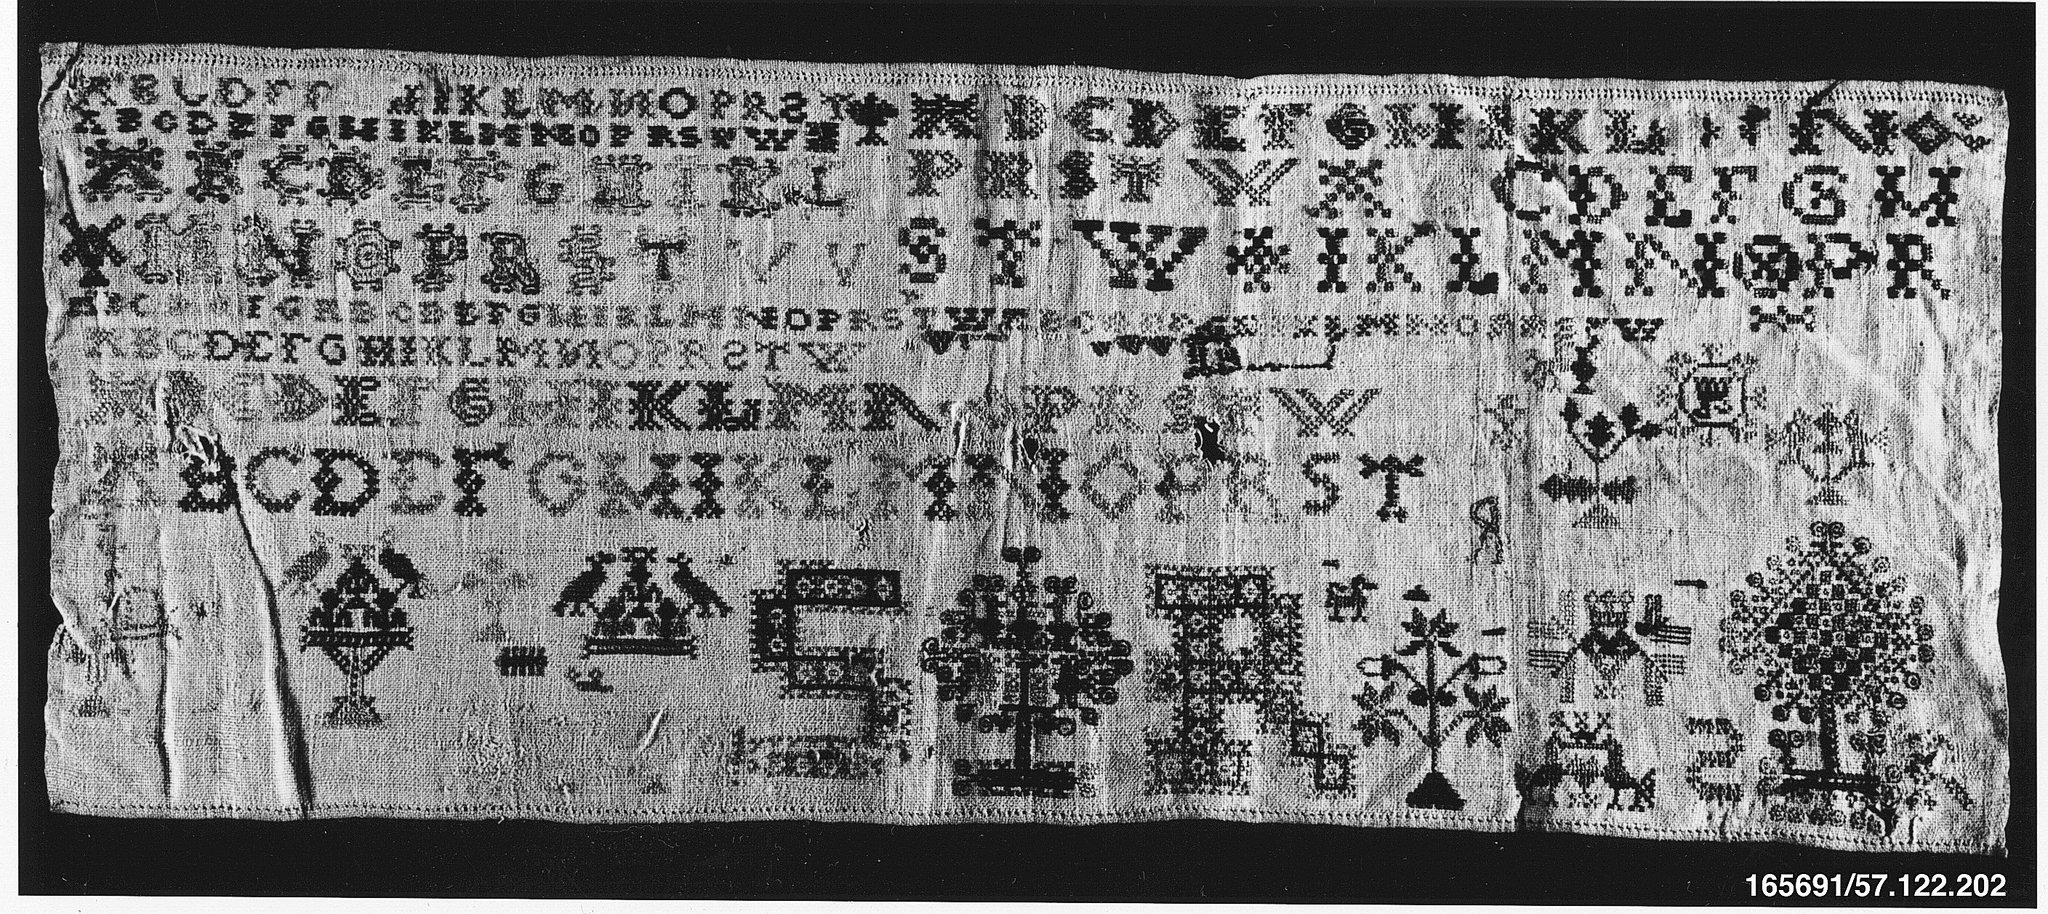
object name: sampler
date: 1701-1800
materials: linen, silk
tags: birds